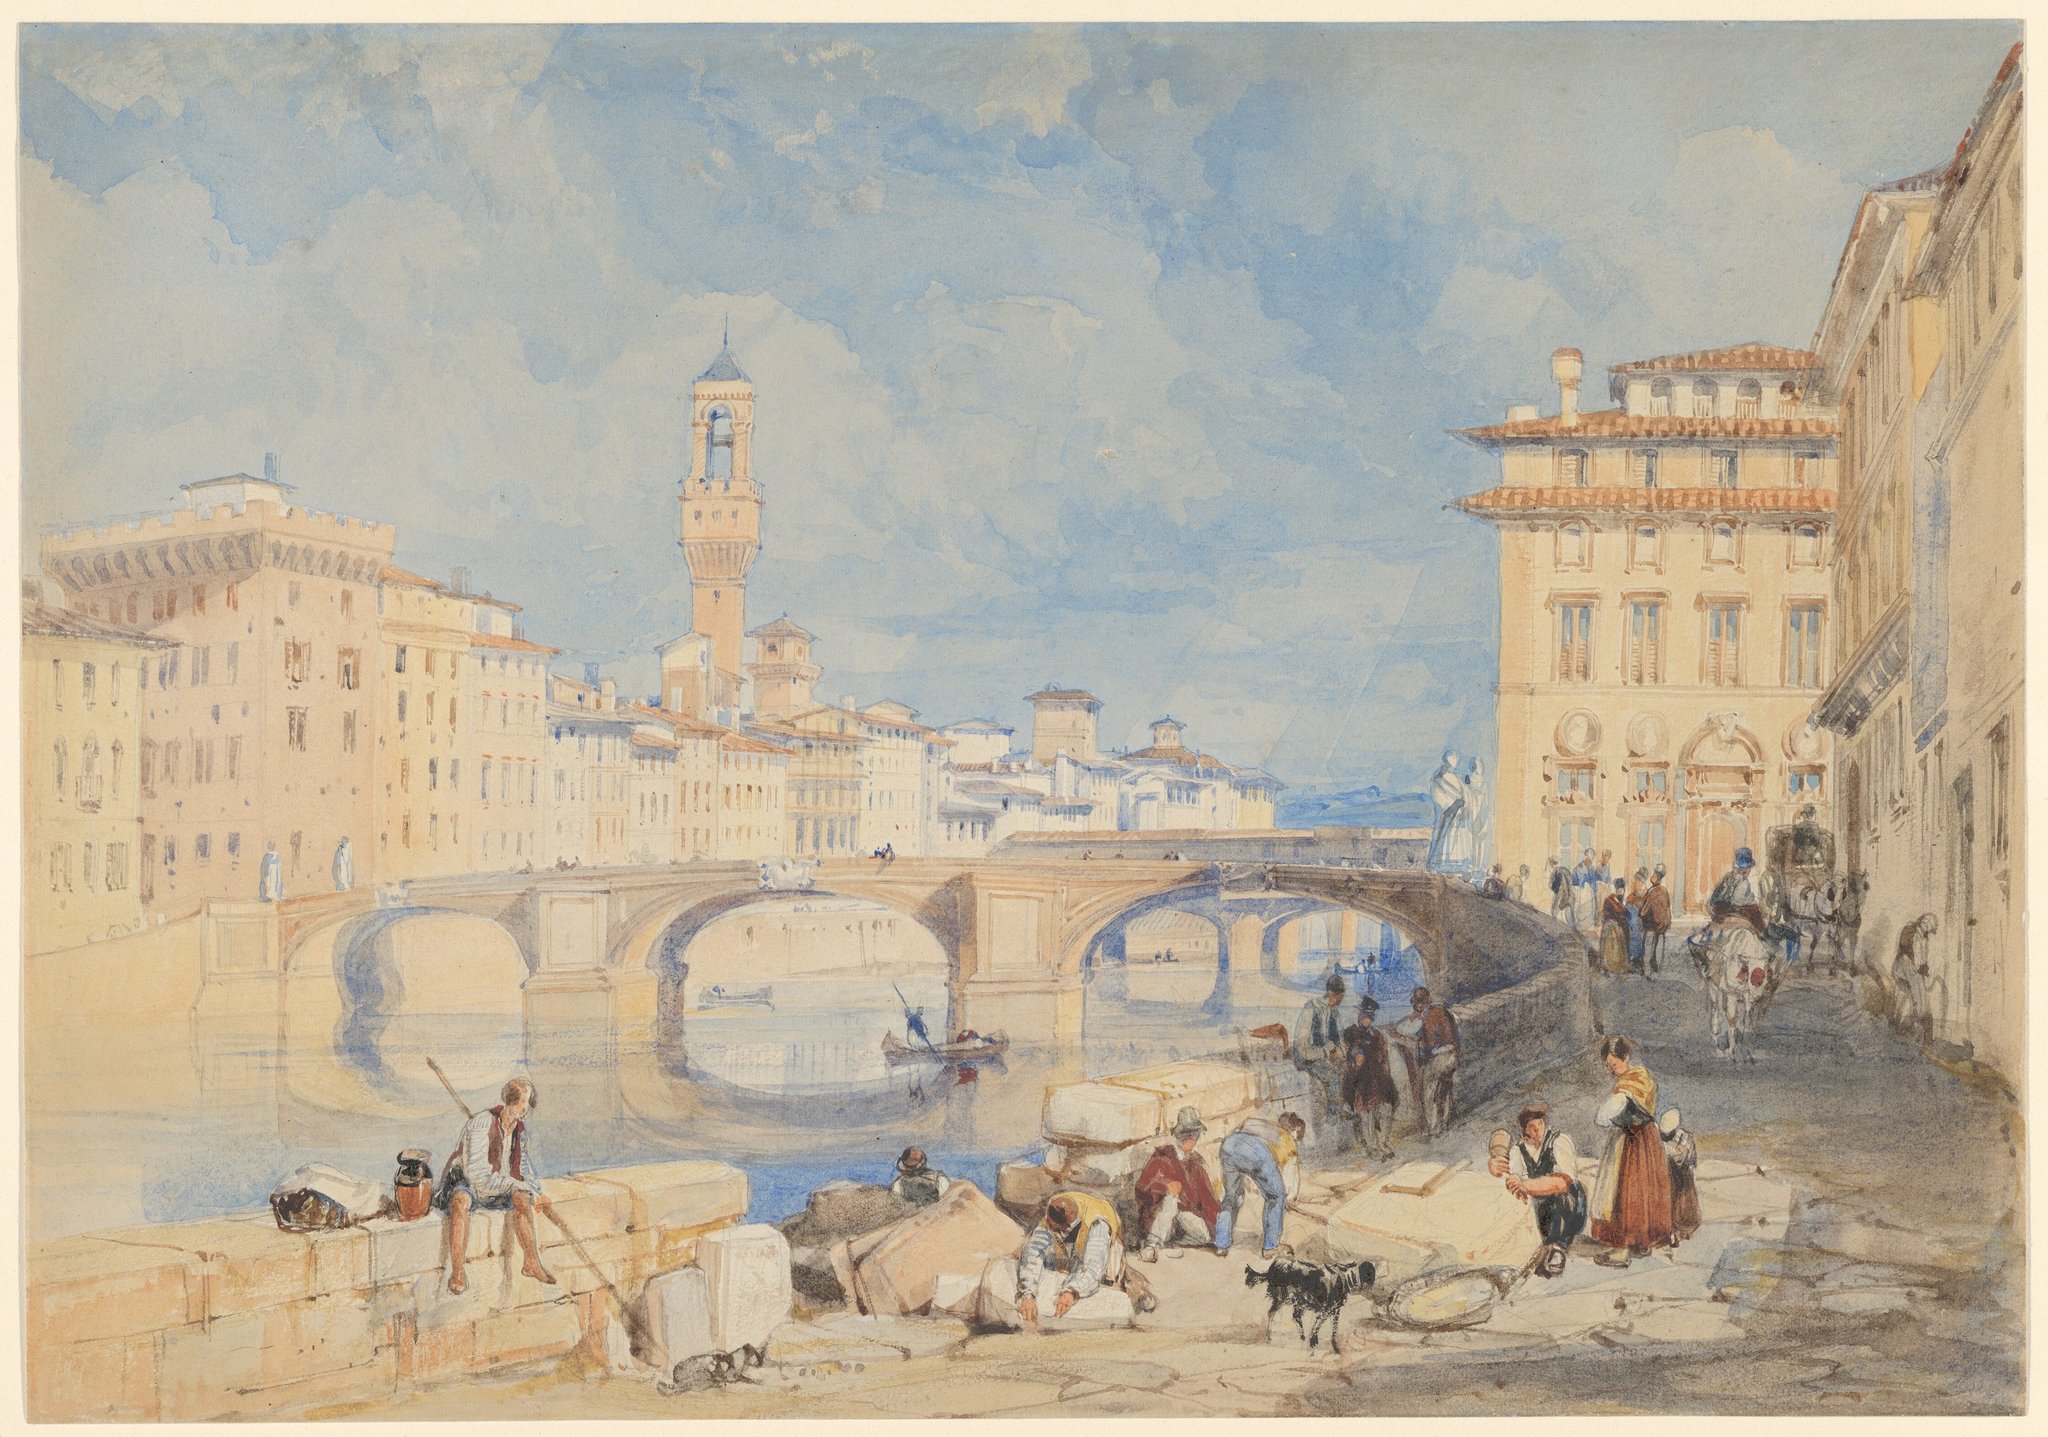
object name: drawing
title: Ponte Santa Trinità, Florence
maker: james duffield harding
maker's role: artist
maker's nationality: british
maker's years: 1797-1863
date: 1832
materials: graphite, watercolor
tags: buildings,bridges,men,women,canals